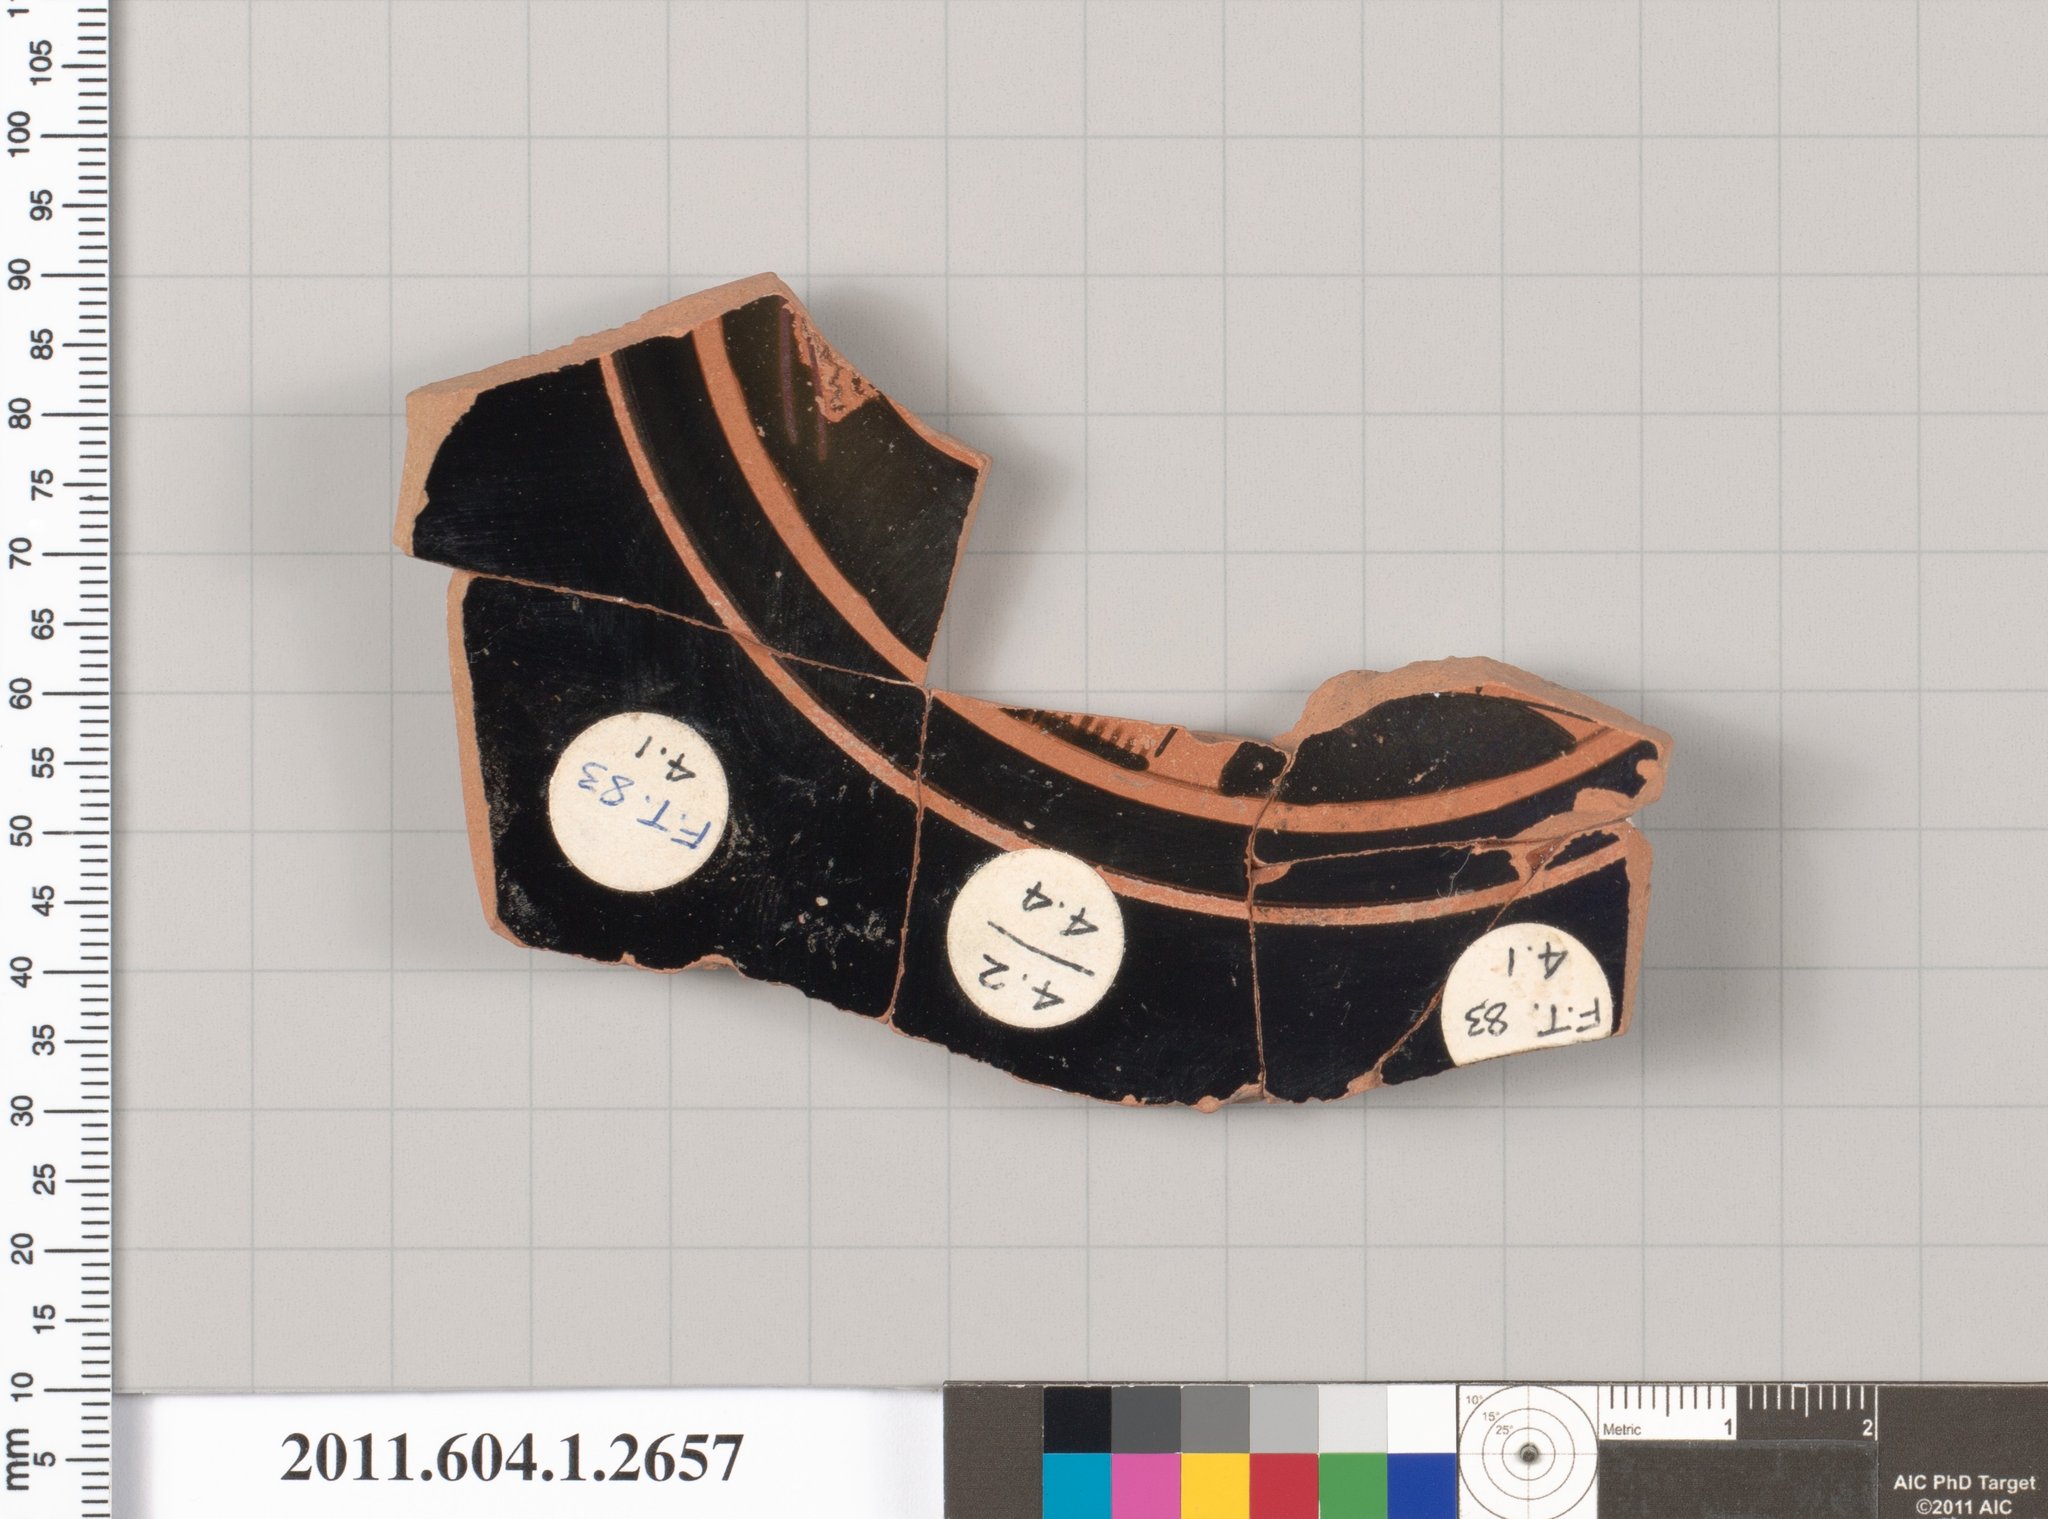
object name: kylix fragment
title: Terracotta fragment of a kylix (drinking cup)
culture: greek, attic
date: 475-451 BCE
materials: terracotta